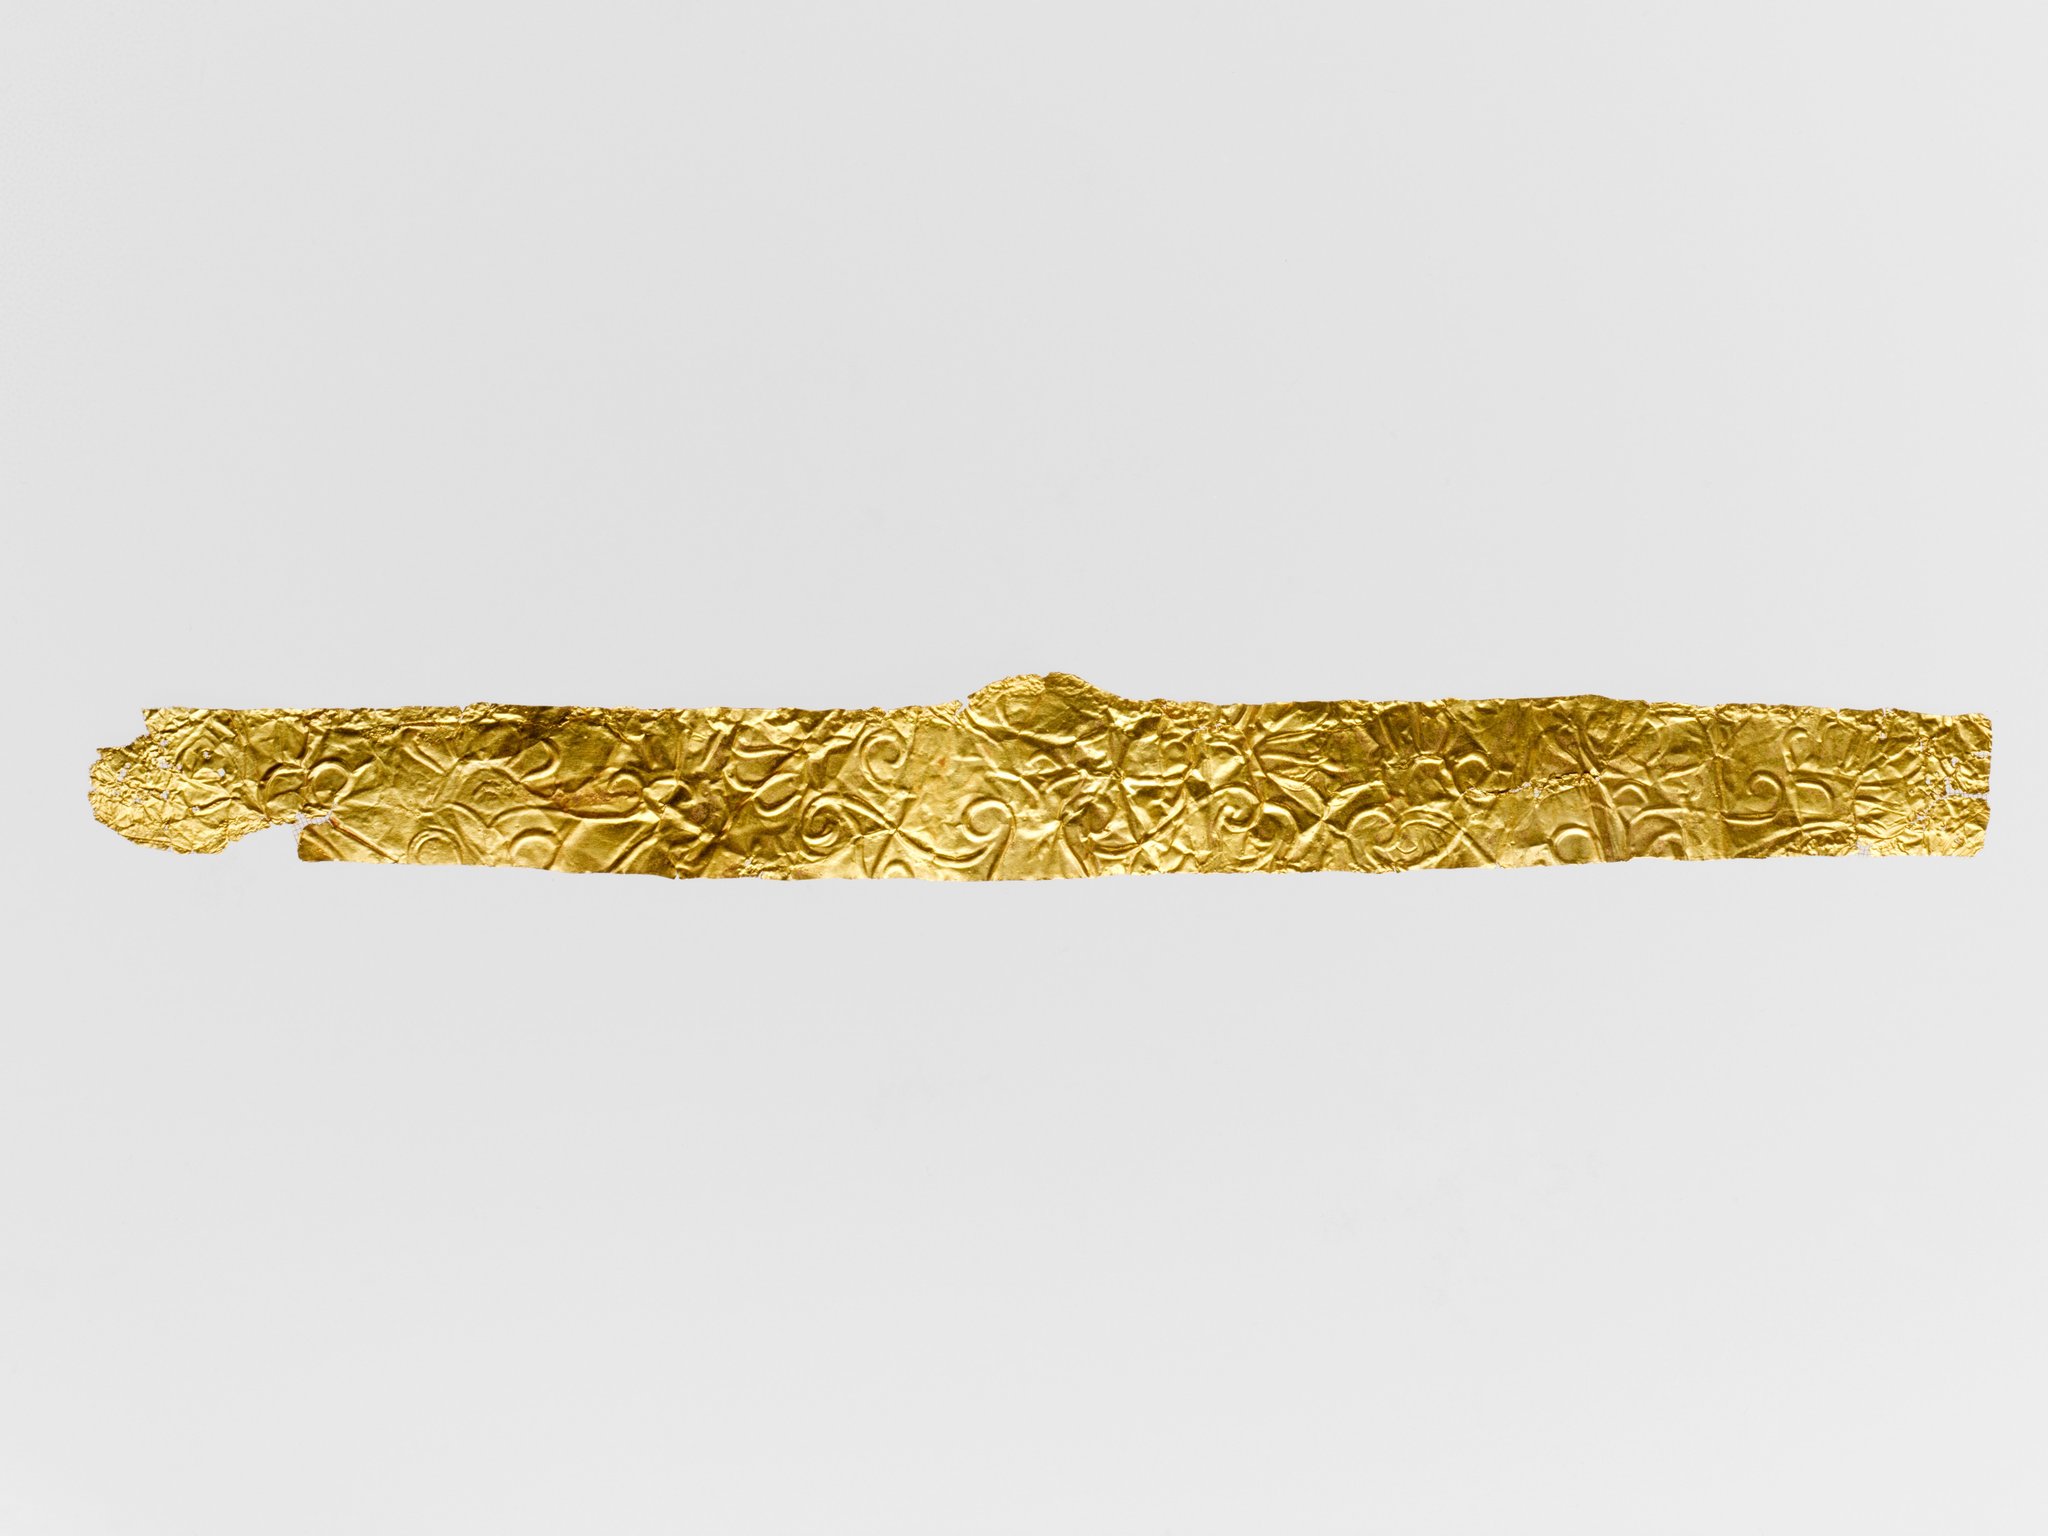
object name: diadem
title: Gold diadem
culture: cypriot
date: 400-301 BCE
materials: gold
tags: diadems